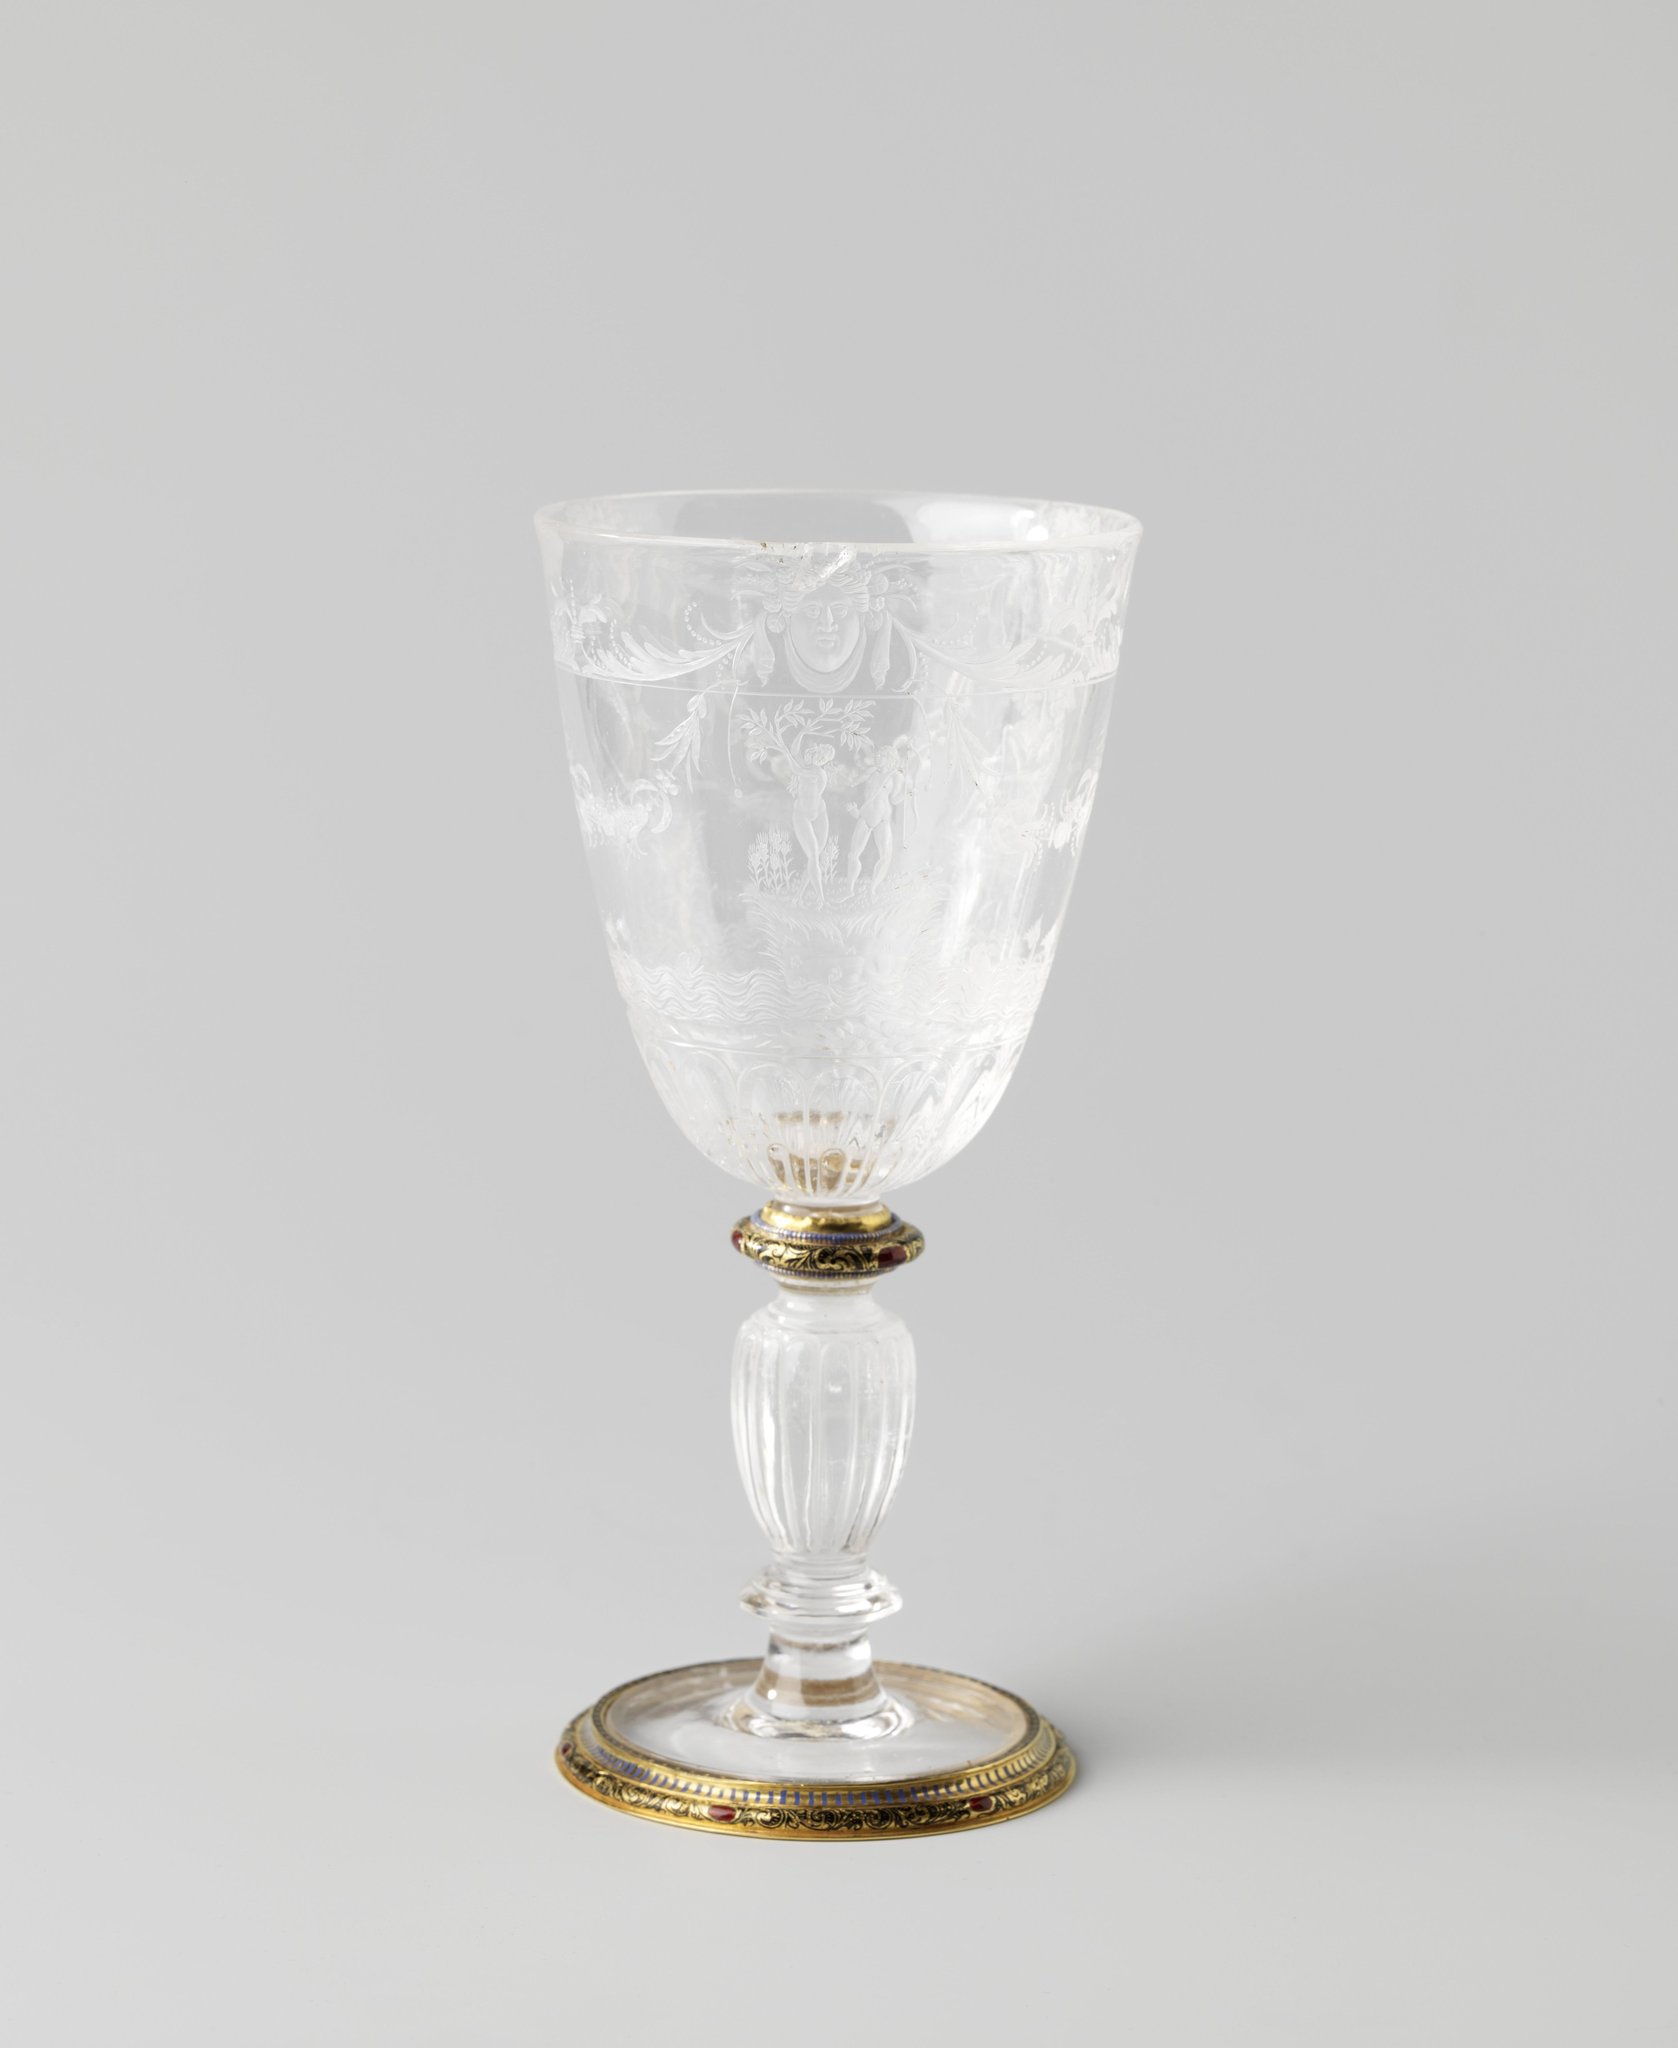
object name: drinking glass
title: Goblet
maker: Anonymous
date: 1550-1575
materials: gold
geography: milan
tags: diana (luna) visiting the sleeping endymion, jupiter, in the shape of a swan, and leda, apollo pursuing the nymph daphne (as yet not metamorphosed)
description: Mythological amorous couples are portrayed on the bowl of this goblet: Apollo and Daphne, Diana and Endymion, and Leda and Jupiter. These depictions are virtually identical to ones on a dish signed by the famous Milanese lapidary Francesco Tortorino. He was employed by Emperor Maximilian II in 1569.